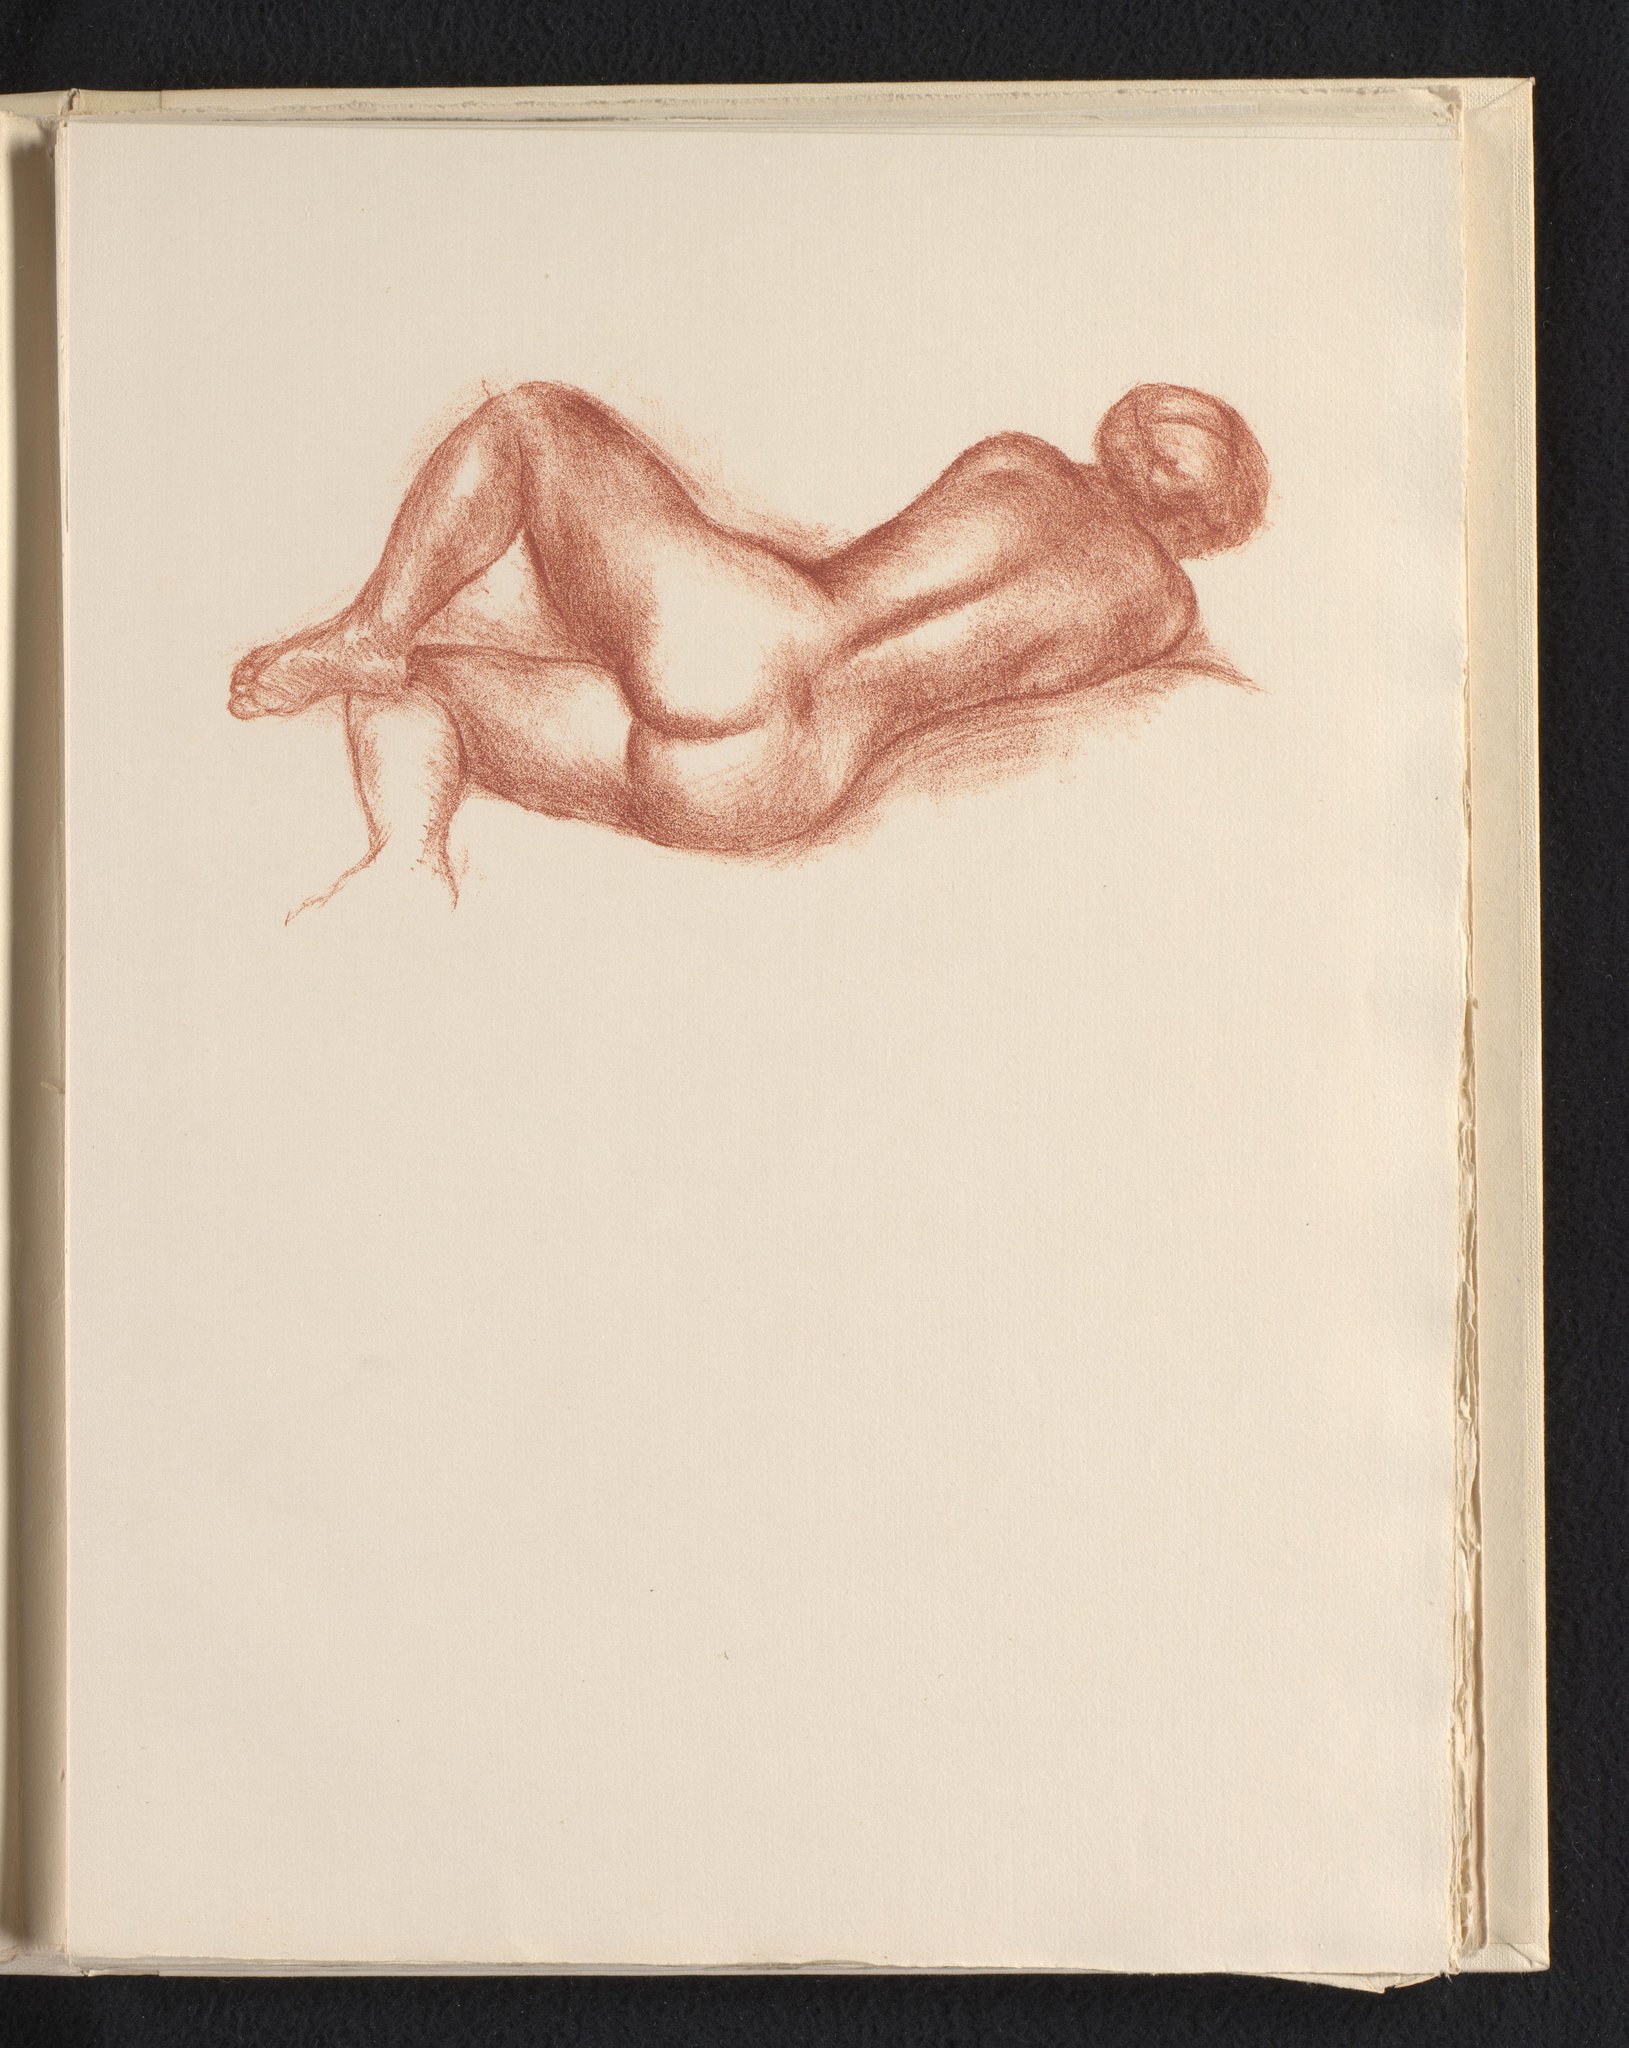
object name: page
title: Liggende naakte vrouw, op de rug gezien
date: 1948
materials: paper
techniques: lithograph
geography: paris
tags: lying on one side, stretched out - aa - female human figure, woman (showing herself) undressed, quasi-nude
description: Prent uit: Lucianus van Samosata. Dialogues des Courtisanes. [Vertaald uit het Grieks door] Charles Astruc. Parijs: s.n., 1948, deel van de suite met een extra afdruk van de prenten in sanguine.